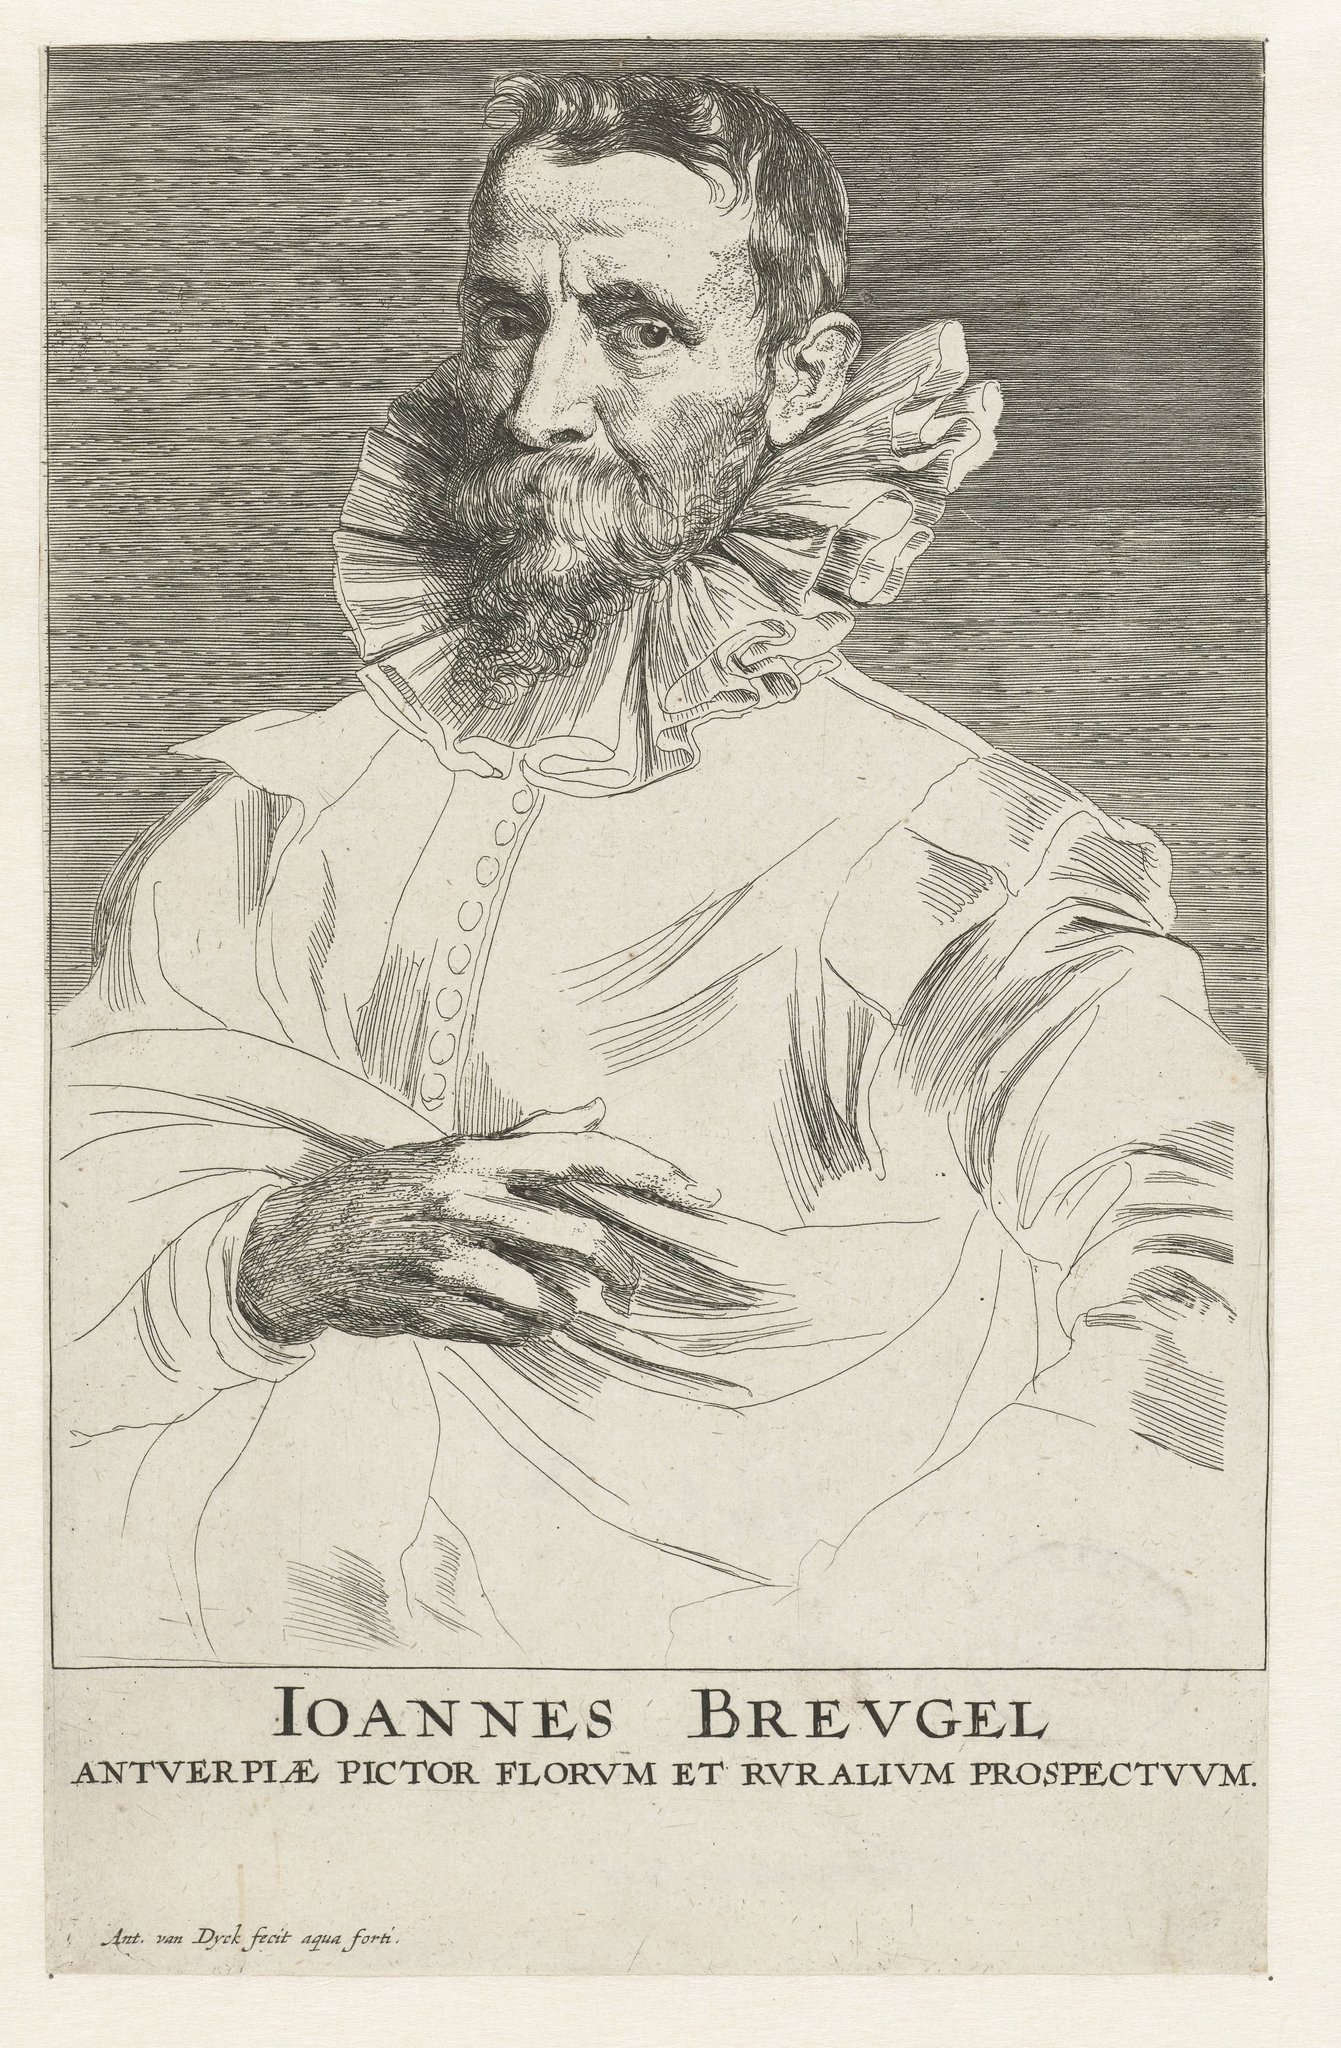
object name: print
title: Portret van Jan Brueghel de Oude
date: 1630-1632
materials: paper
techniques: etching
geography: low countries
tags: brussels, antwerp, painter, print maker, jan brueghel (i), portrait, self-portrait of painter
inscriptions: collector's mark: Lugt 240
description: Portret van Jan Brueghel de Oude met opschrift IOANNES BREVGHEL ANTVERPIAE PICTOR FLORVM ET RVRALIVM PROSPECTVVM